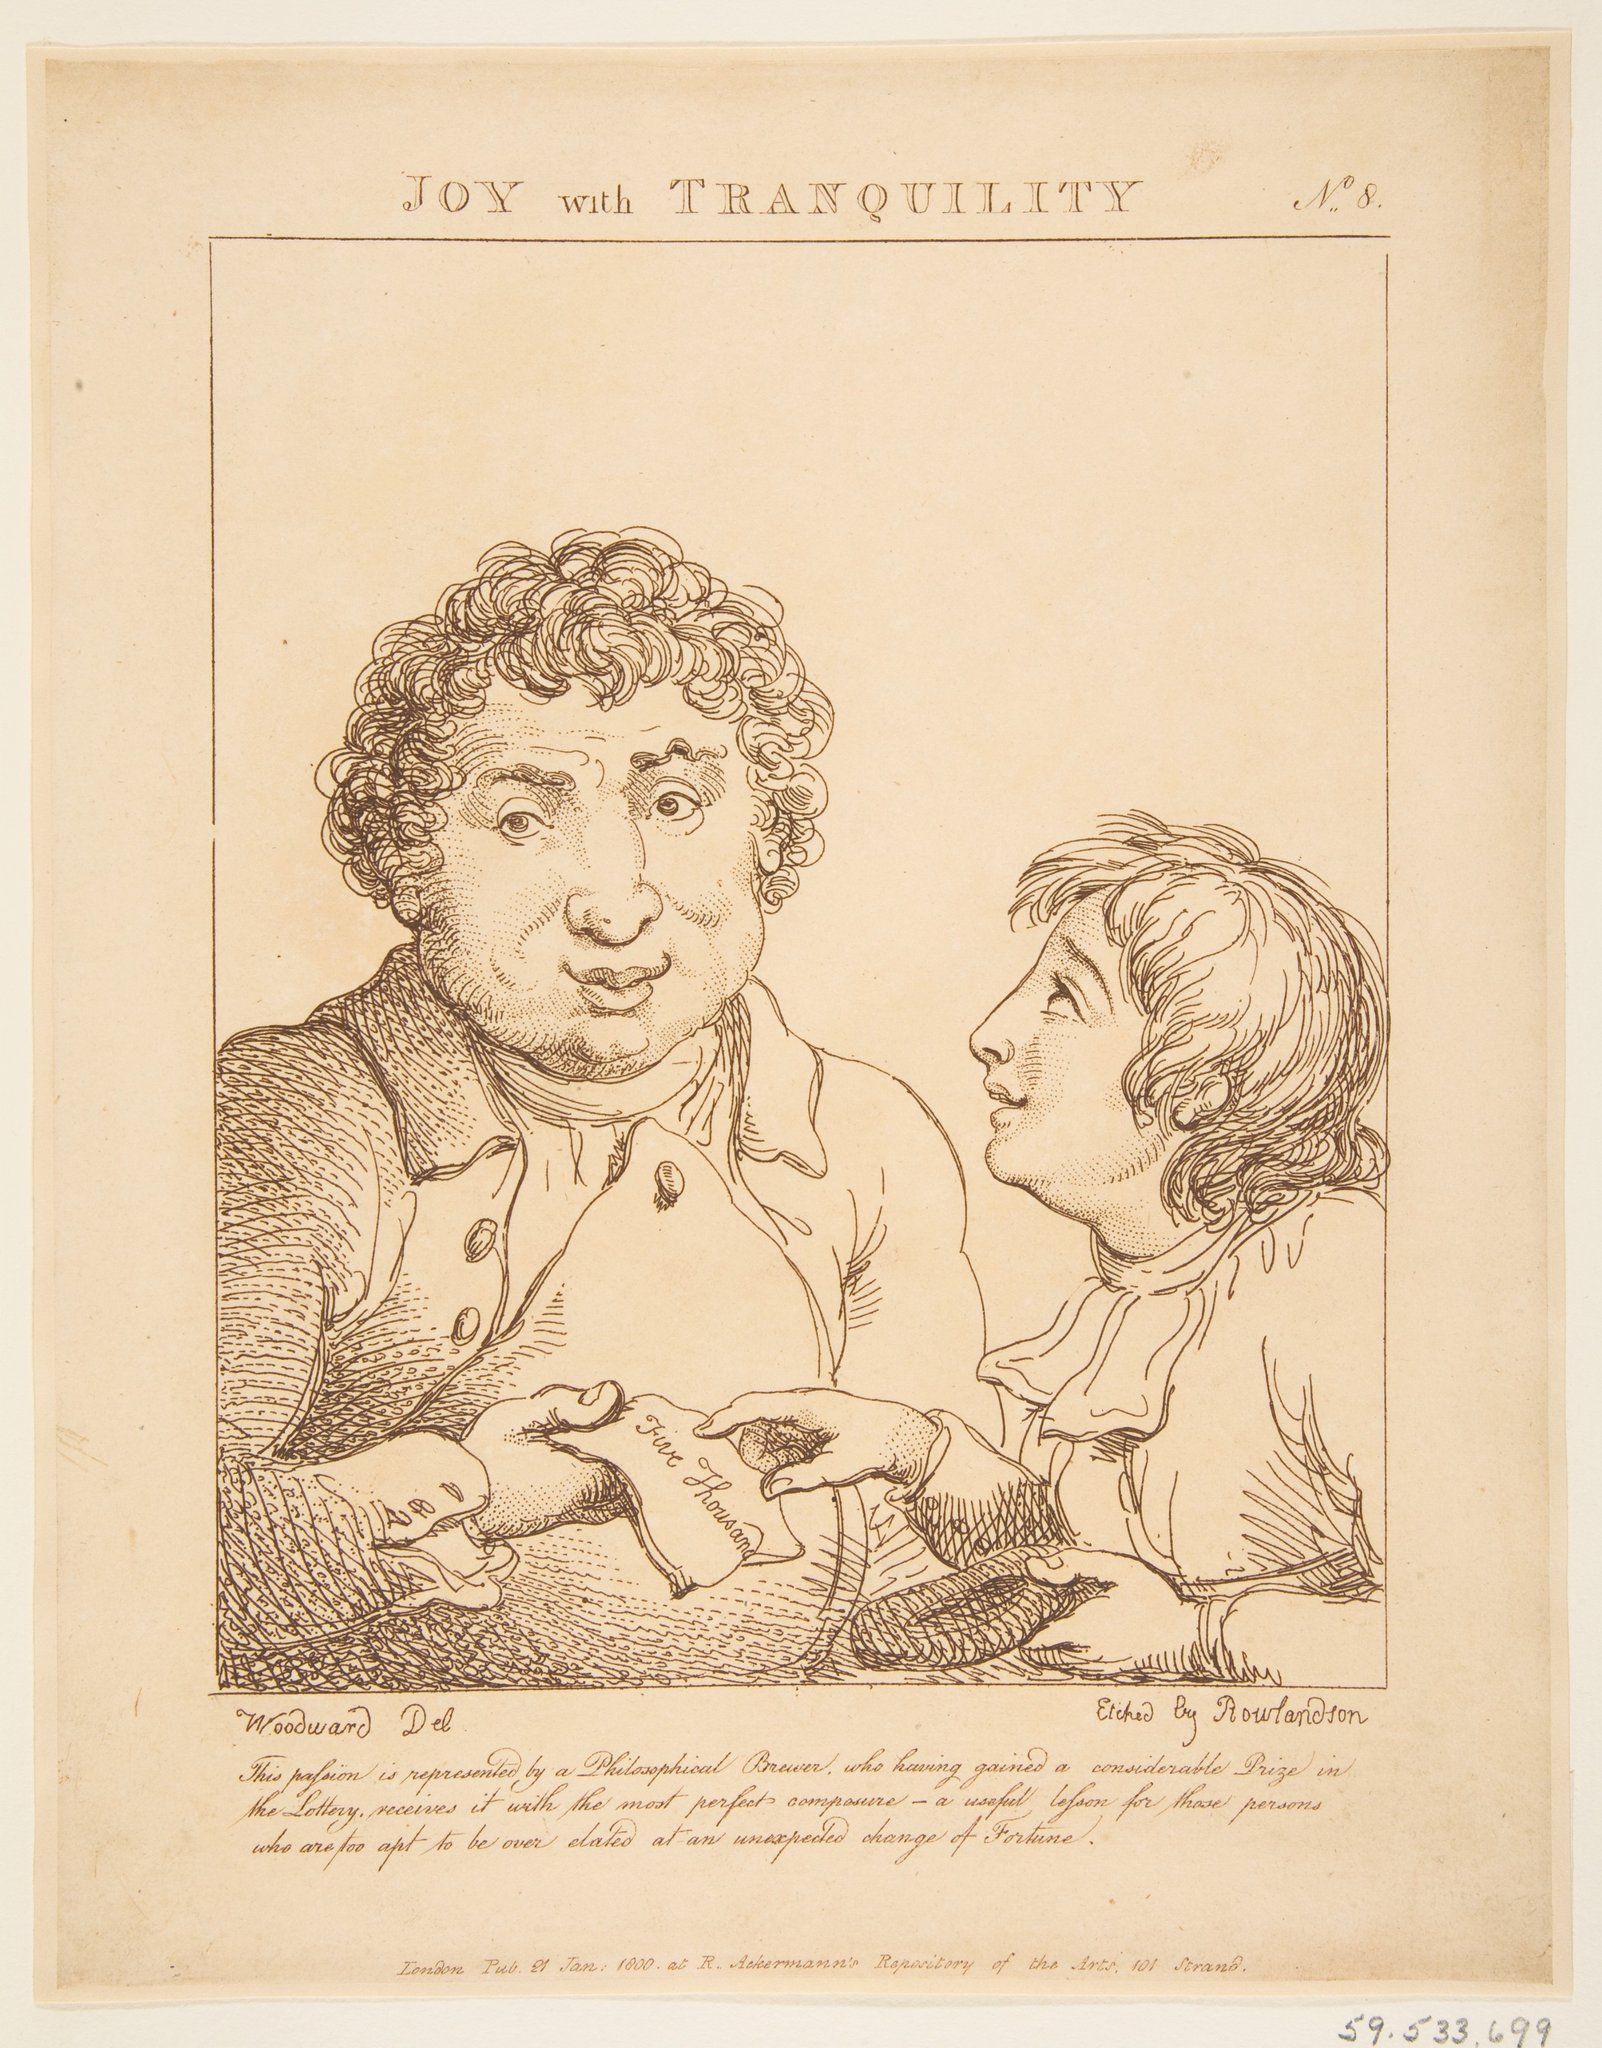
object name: print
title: Joy with Tranquility (Le Brun Travested, or Caricatures of the Passions)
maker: thomas rowlandson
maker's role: artist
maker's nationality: british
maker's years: 1757-1827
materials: ink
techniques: etching, printing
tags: men